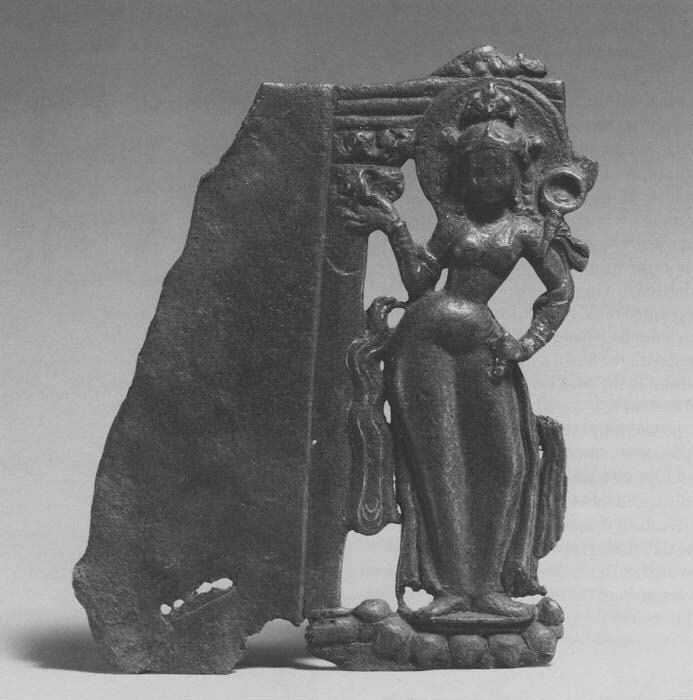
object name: fragment of halo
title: Standing Female Deity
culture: pakistani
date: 601-700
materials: bronze, gold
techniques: inlay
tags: swat valley,deities